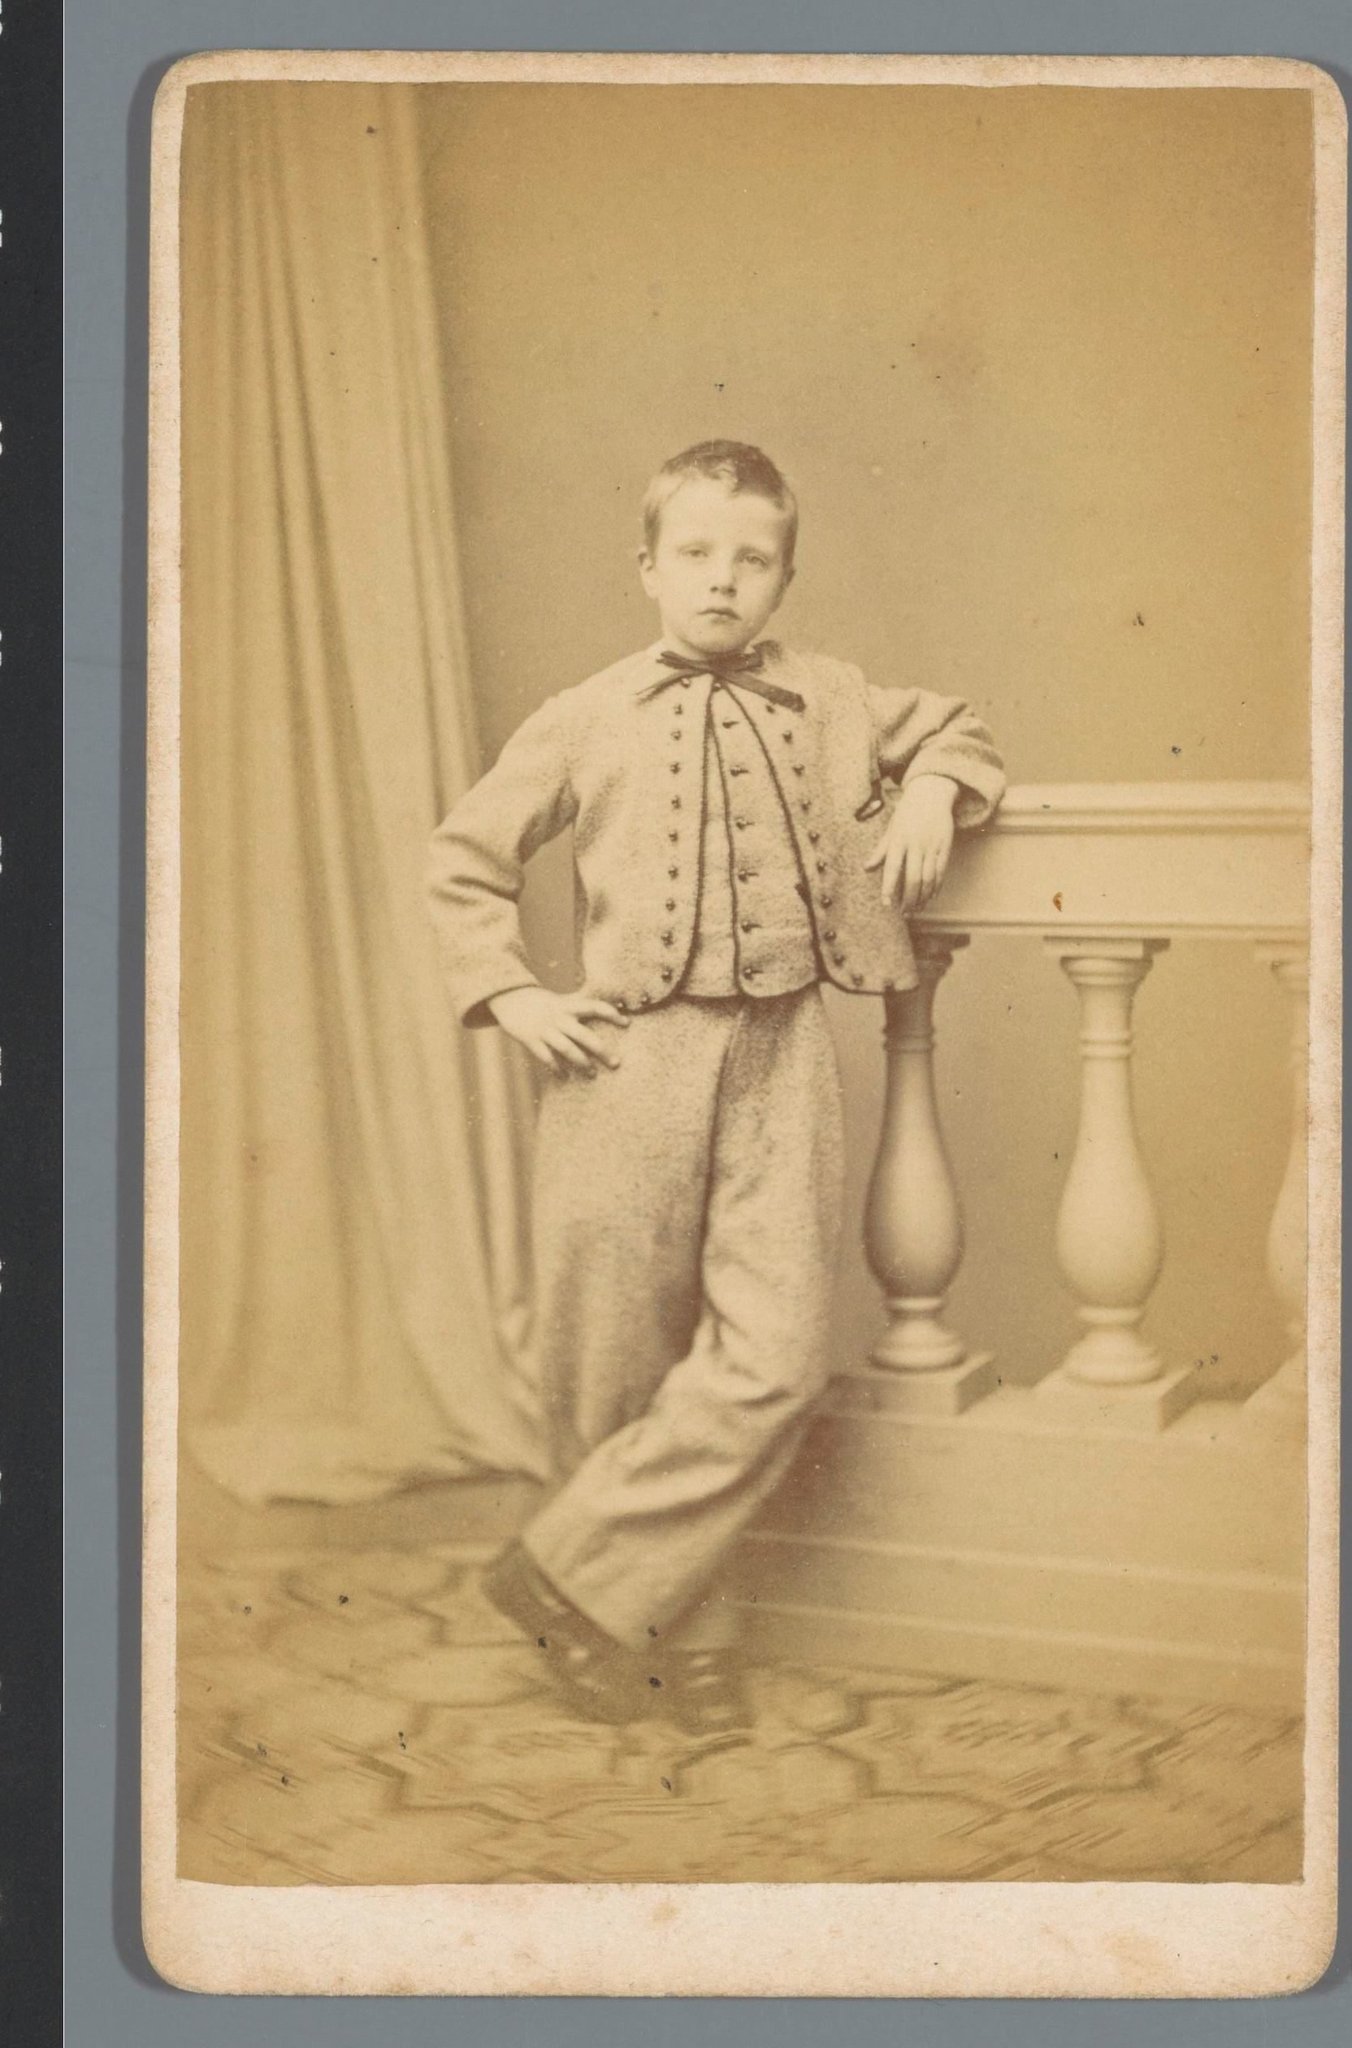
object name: photograph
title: Portret van een onbekende jongen, leunend over een balustrade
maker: jan breebaard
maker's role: fotograaf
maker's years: 1835-1893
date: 1864-1869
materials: cardboard, paper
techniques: albumen print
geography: zaandijk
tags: boy (child between toddler and youth), historical persons, balustrade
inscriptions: inscription: ‘J. L. BREEBAARD/ PHOTOGRAPH/ ZAANDIJK.’